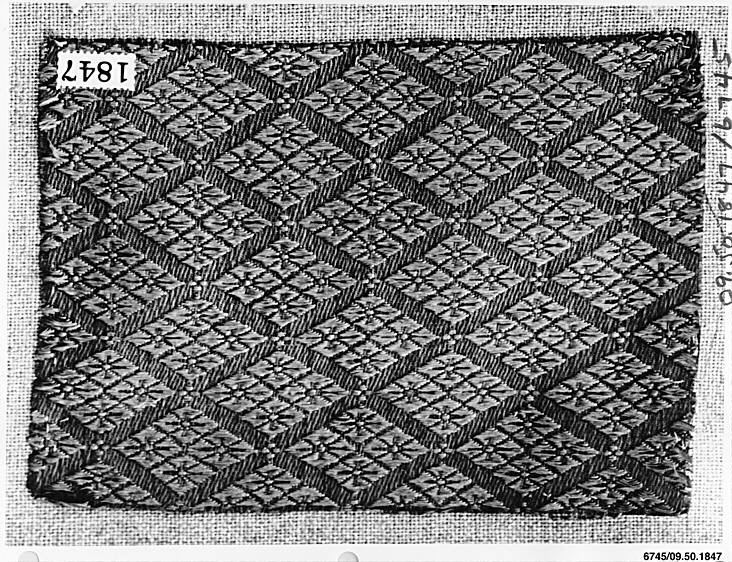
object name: piece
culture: japanese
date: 1615-1868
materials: silk